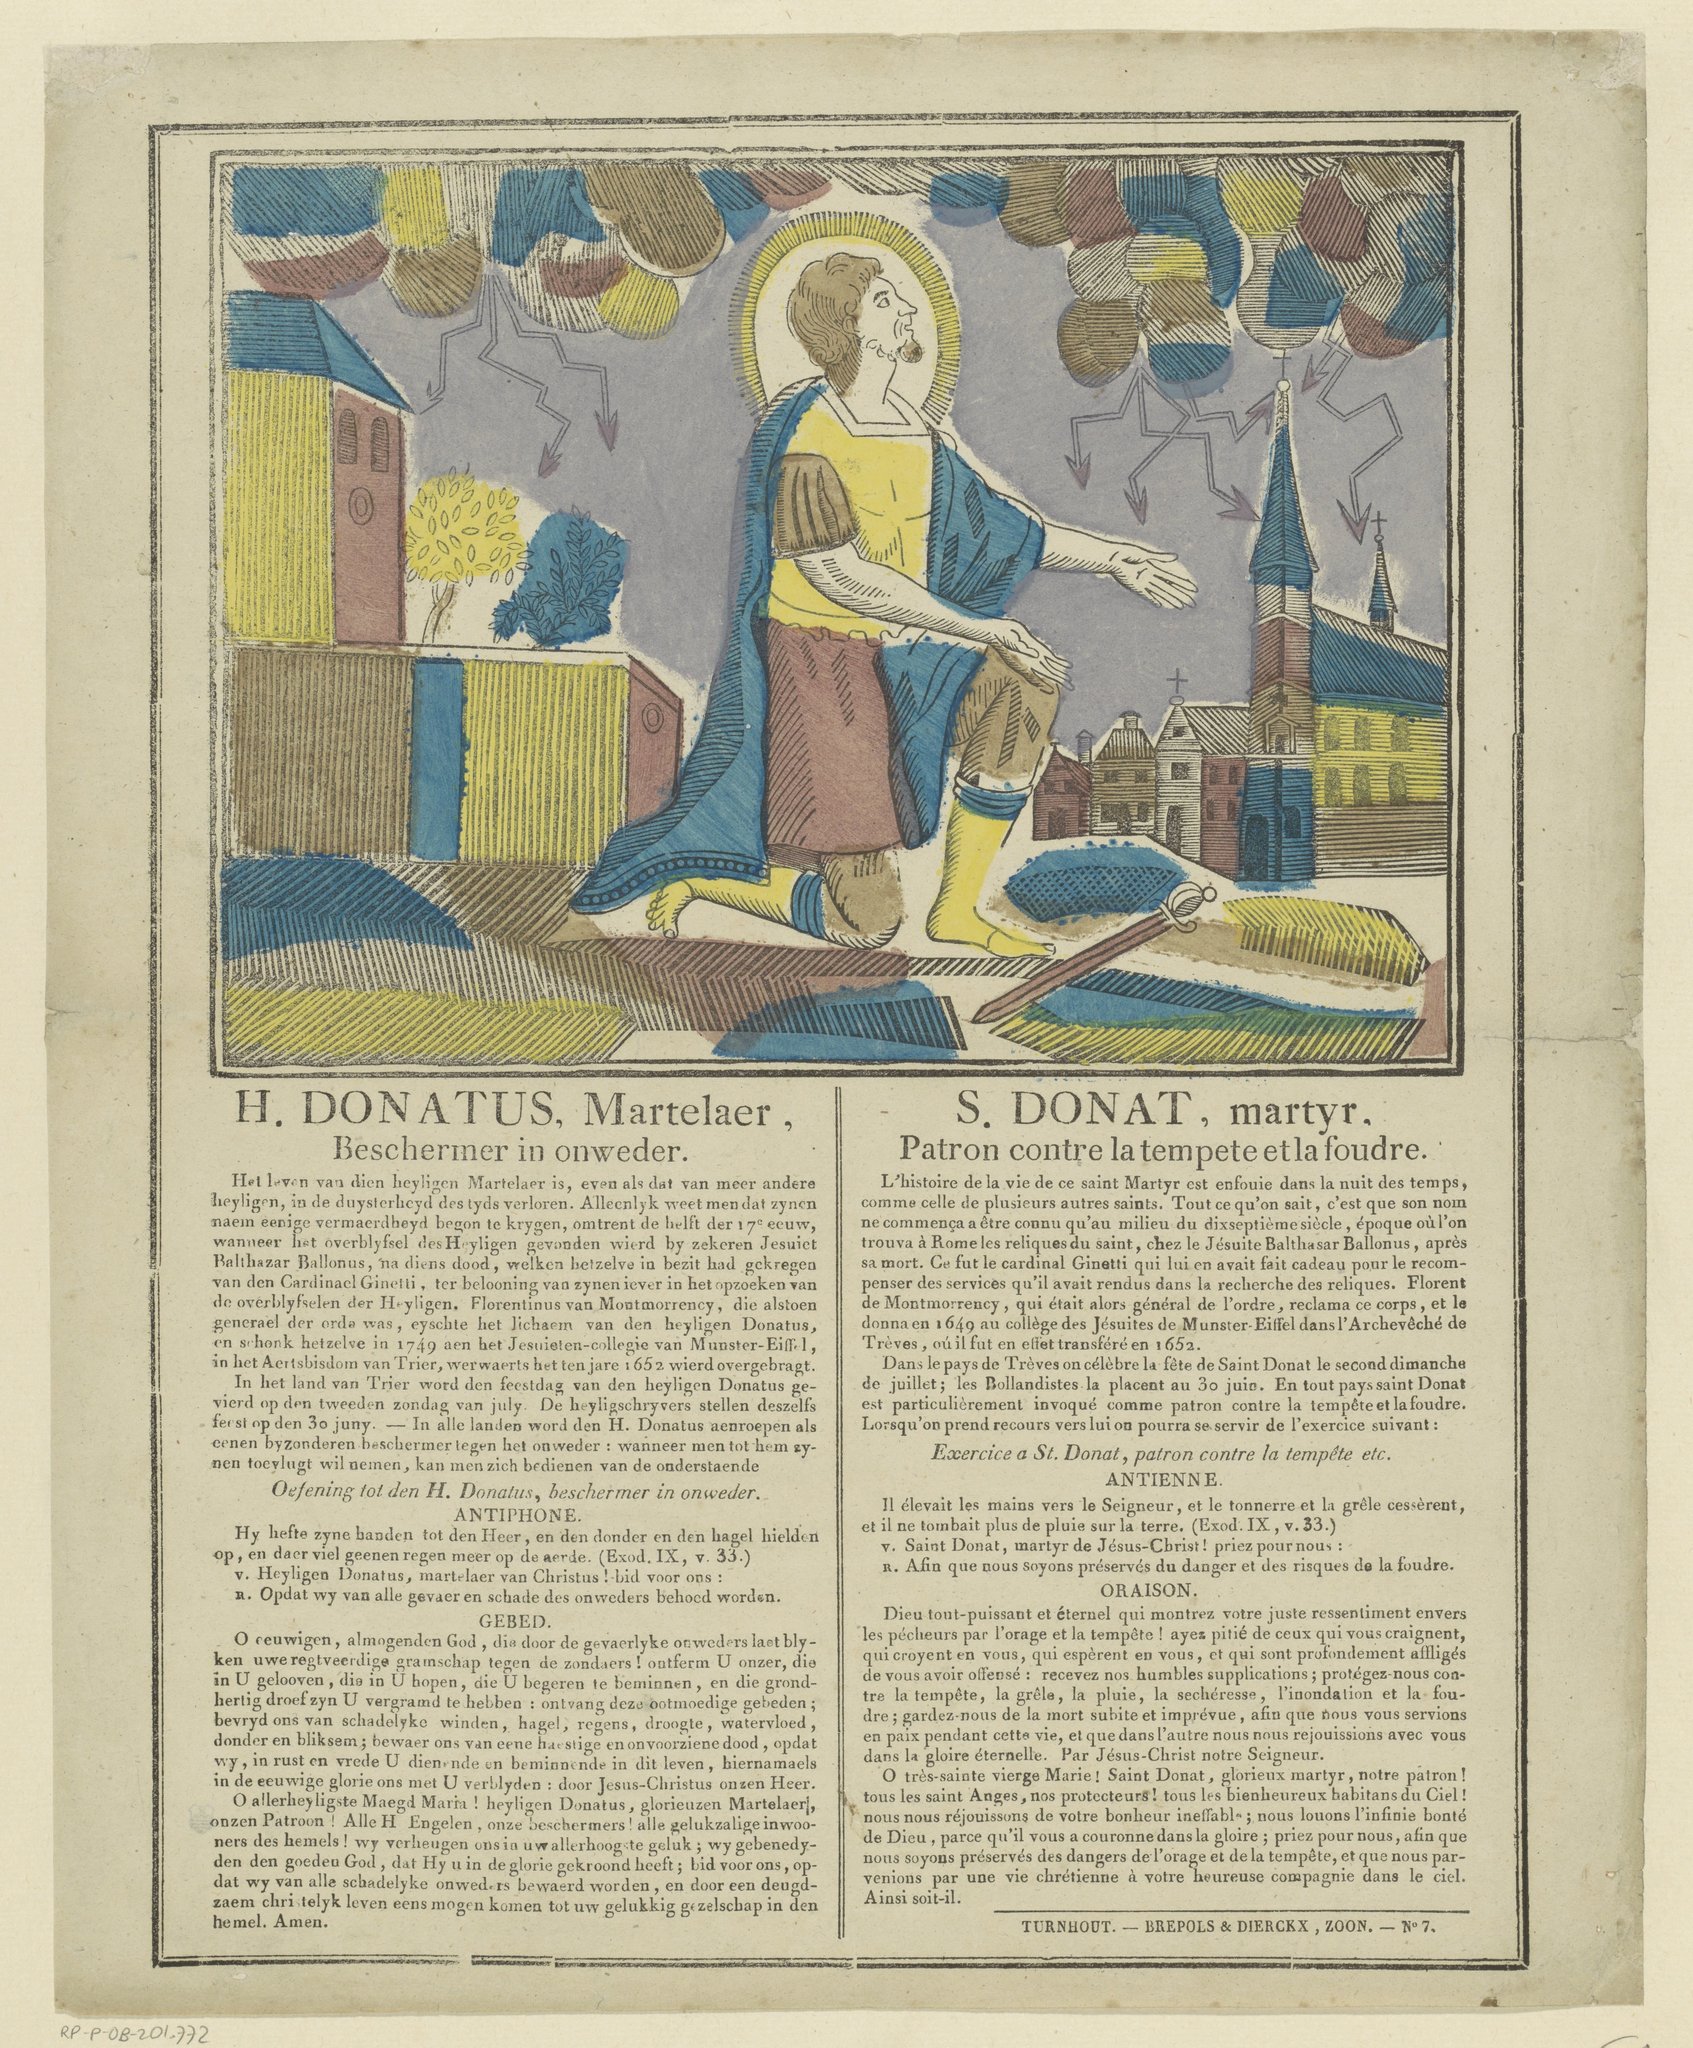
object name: print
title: H. Donatus, martelaer, / Beschermer in onweder / S. Donat, martyr, / Patron contre la tempete et la foudre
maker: Anonymous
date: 1833-1911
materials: paper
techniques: colour, letterpress printing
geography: turnhout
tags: saints, thunderstorm, lightning, flash of lightning, thunderbolt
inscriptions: collector's mark: Lugt 2760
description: De heilige Donatus van Münstereifel zit geknield en kijkt op naar de bliksem in de lucht. Onderschrift in het Nederlands en in het Frans in twee kolommen. Genummerd rechtsonder: No. 7.